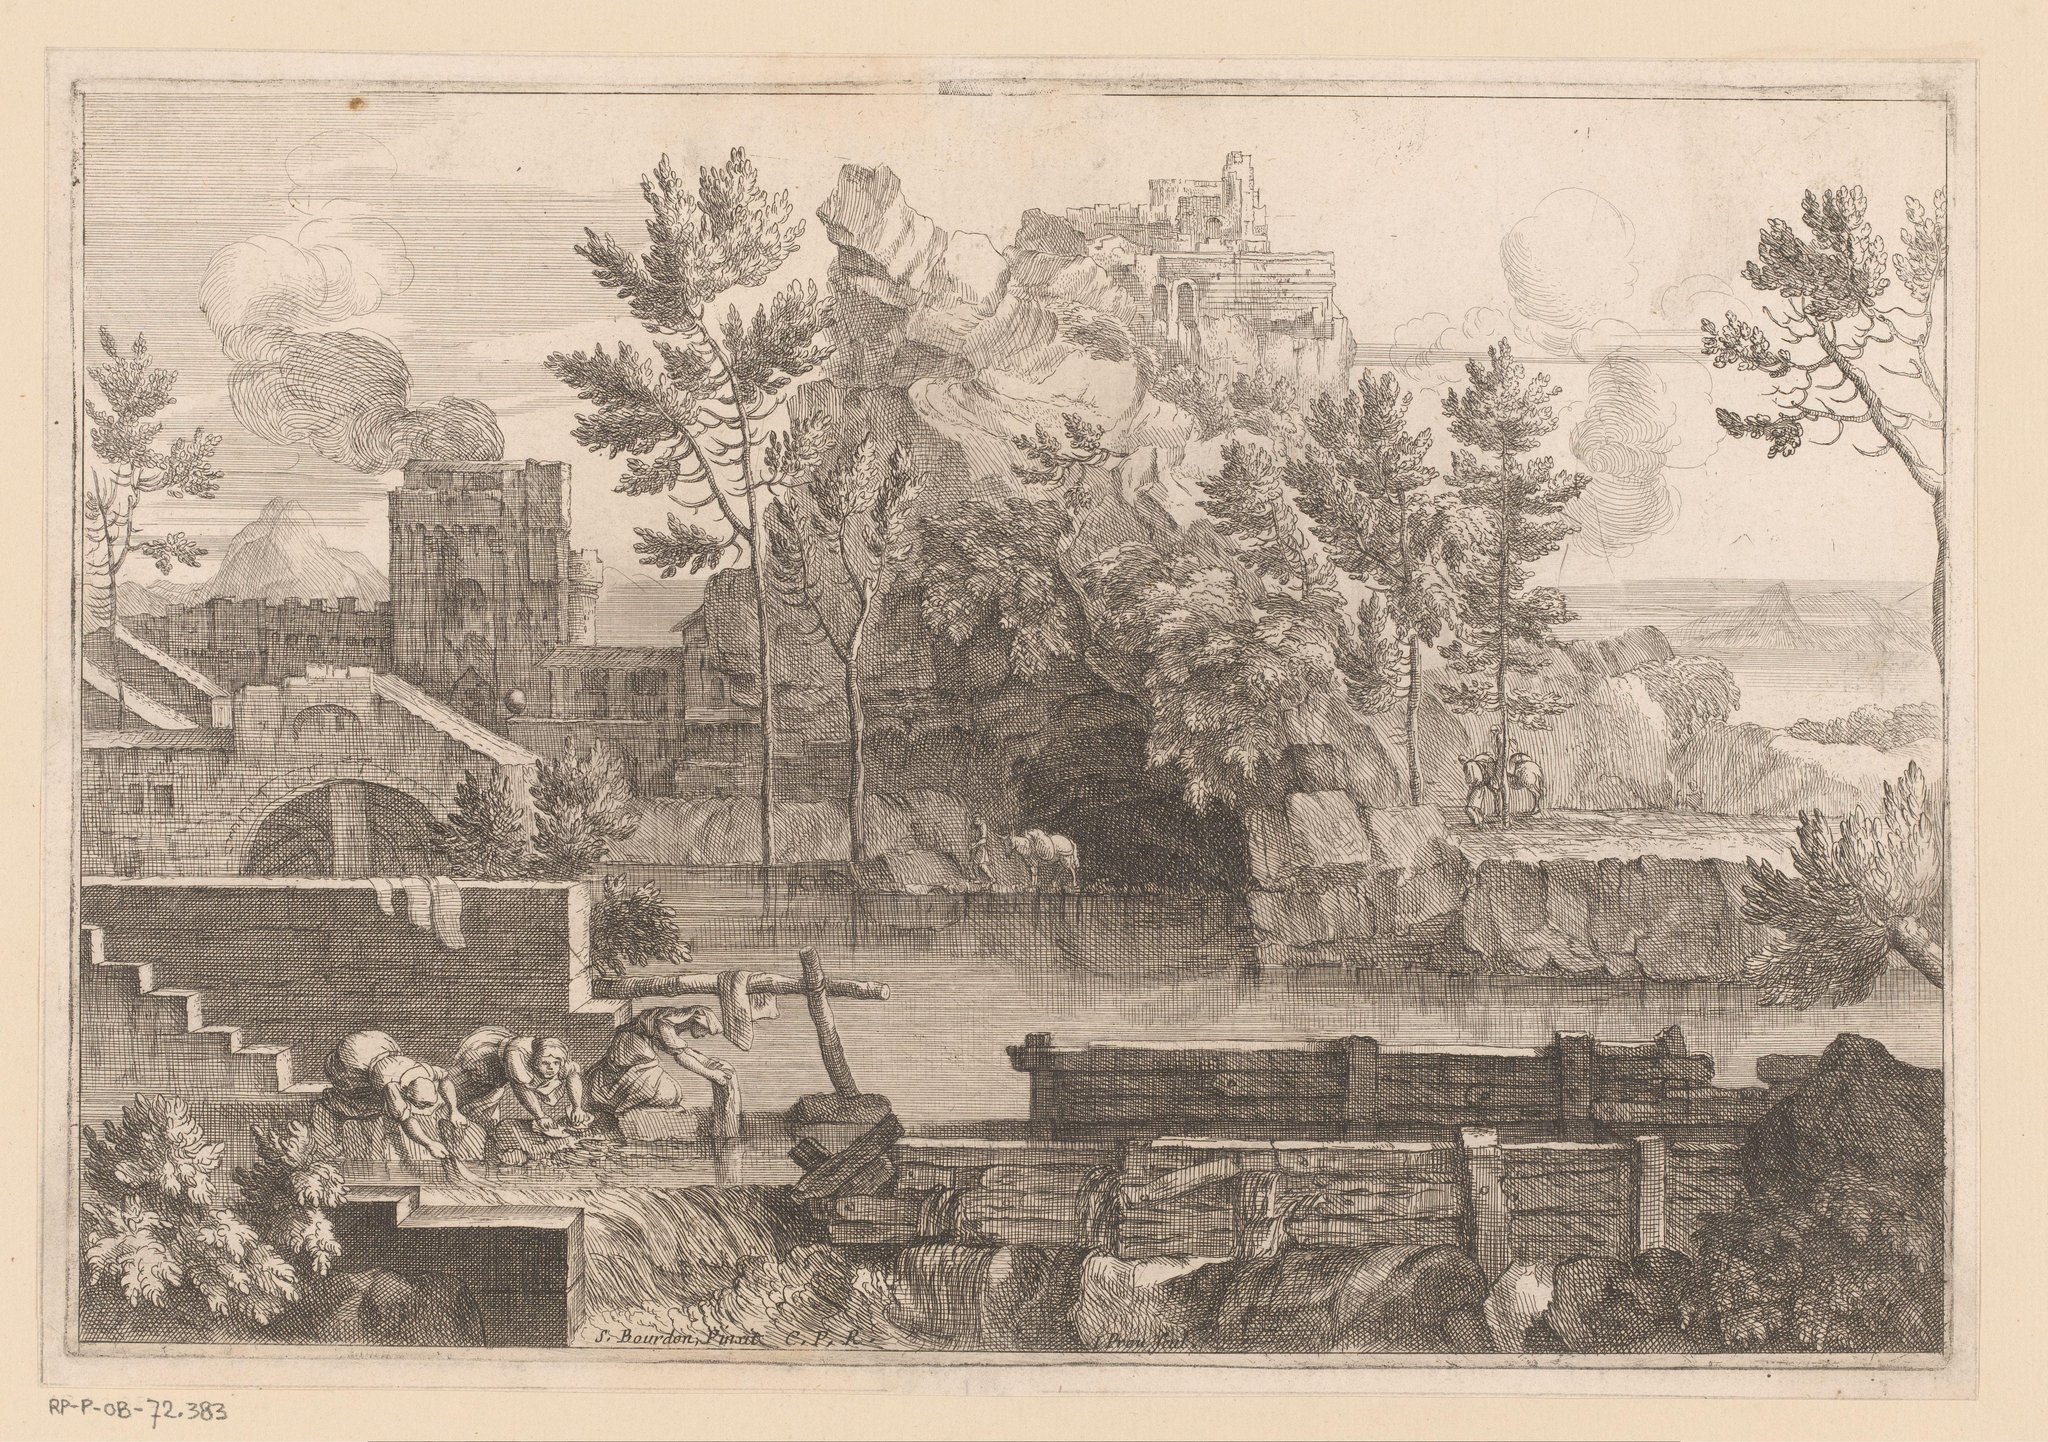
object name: print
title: Landschap met meer en drie wassende vrouwen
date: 1634-1686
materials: paper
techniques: etching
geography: france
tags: landscapes with waters, waterscapes, seascapes (in the temperate zone), laundering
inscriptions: collector's mark: Lugt 240